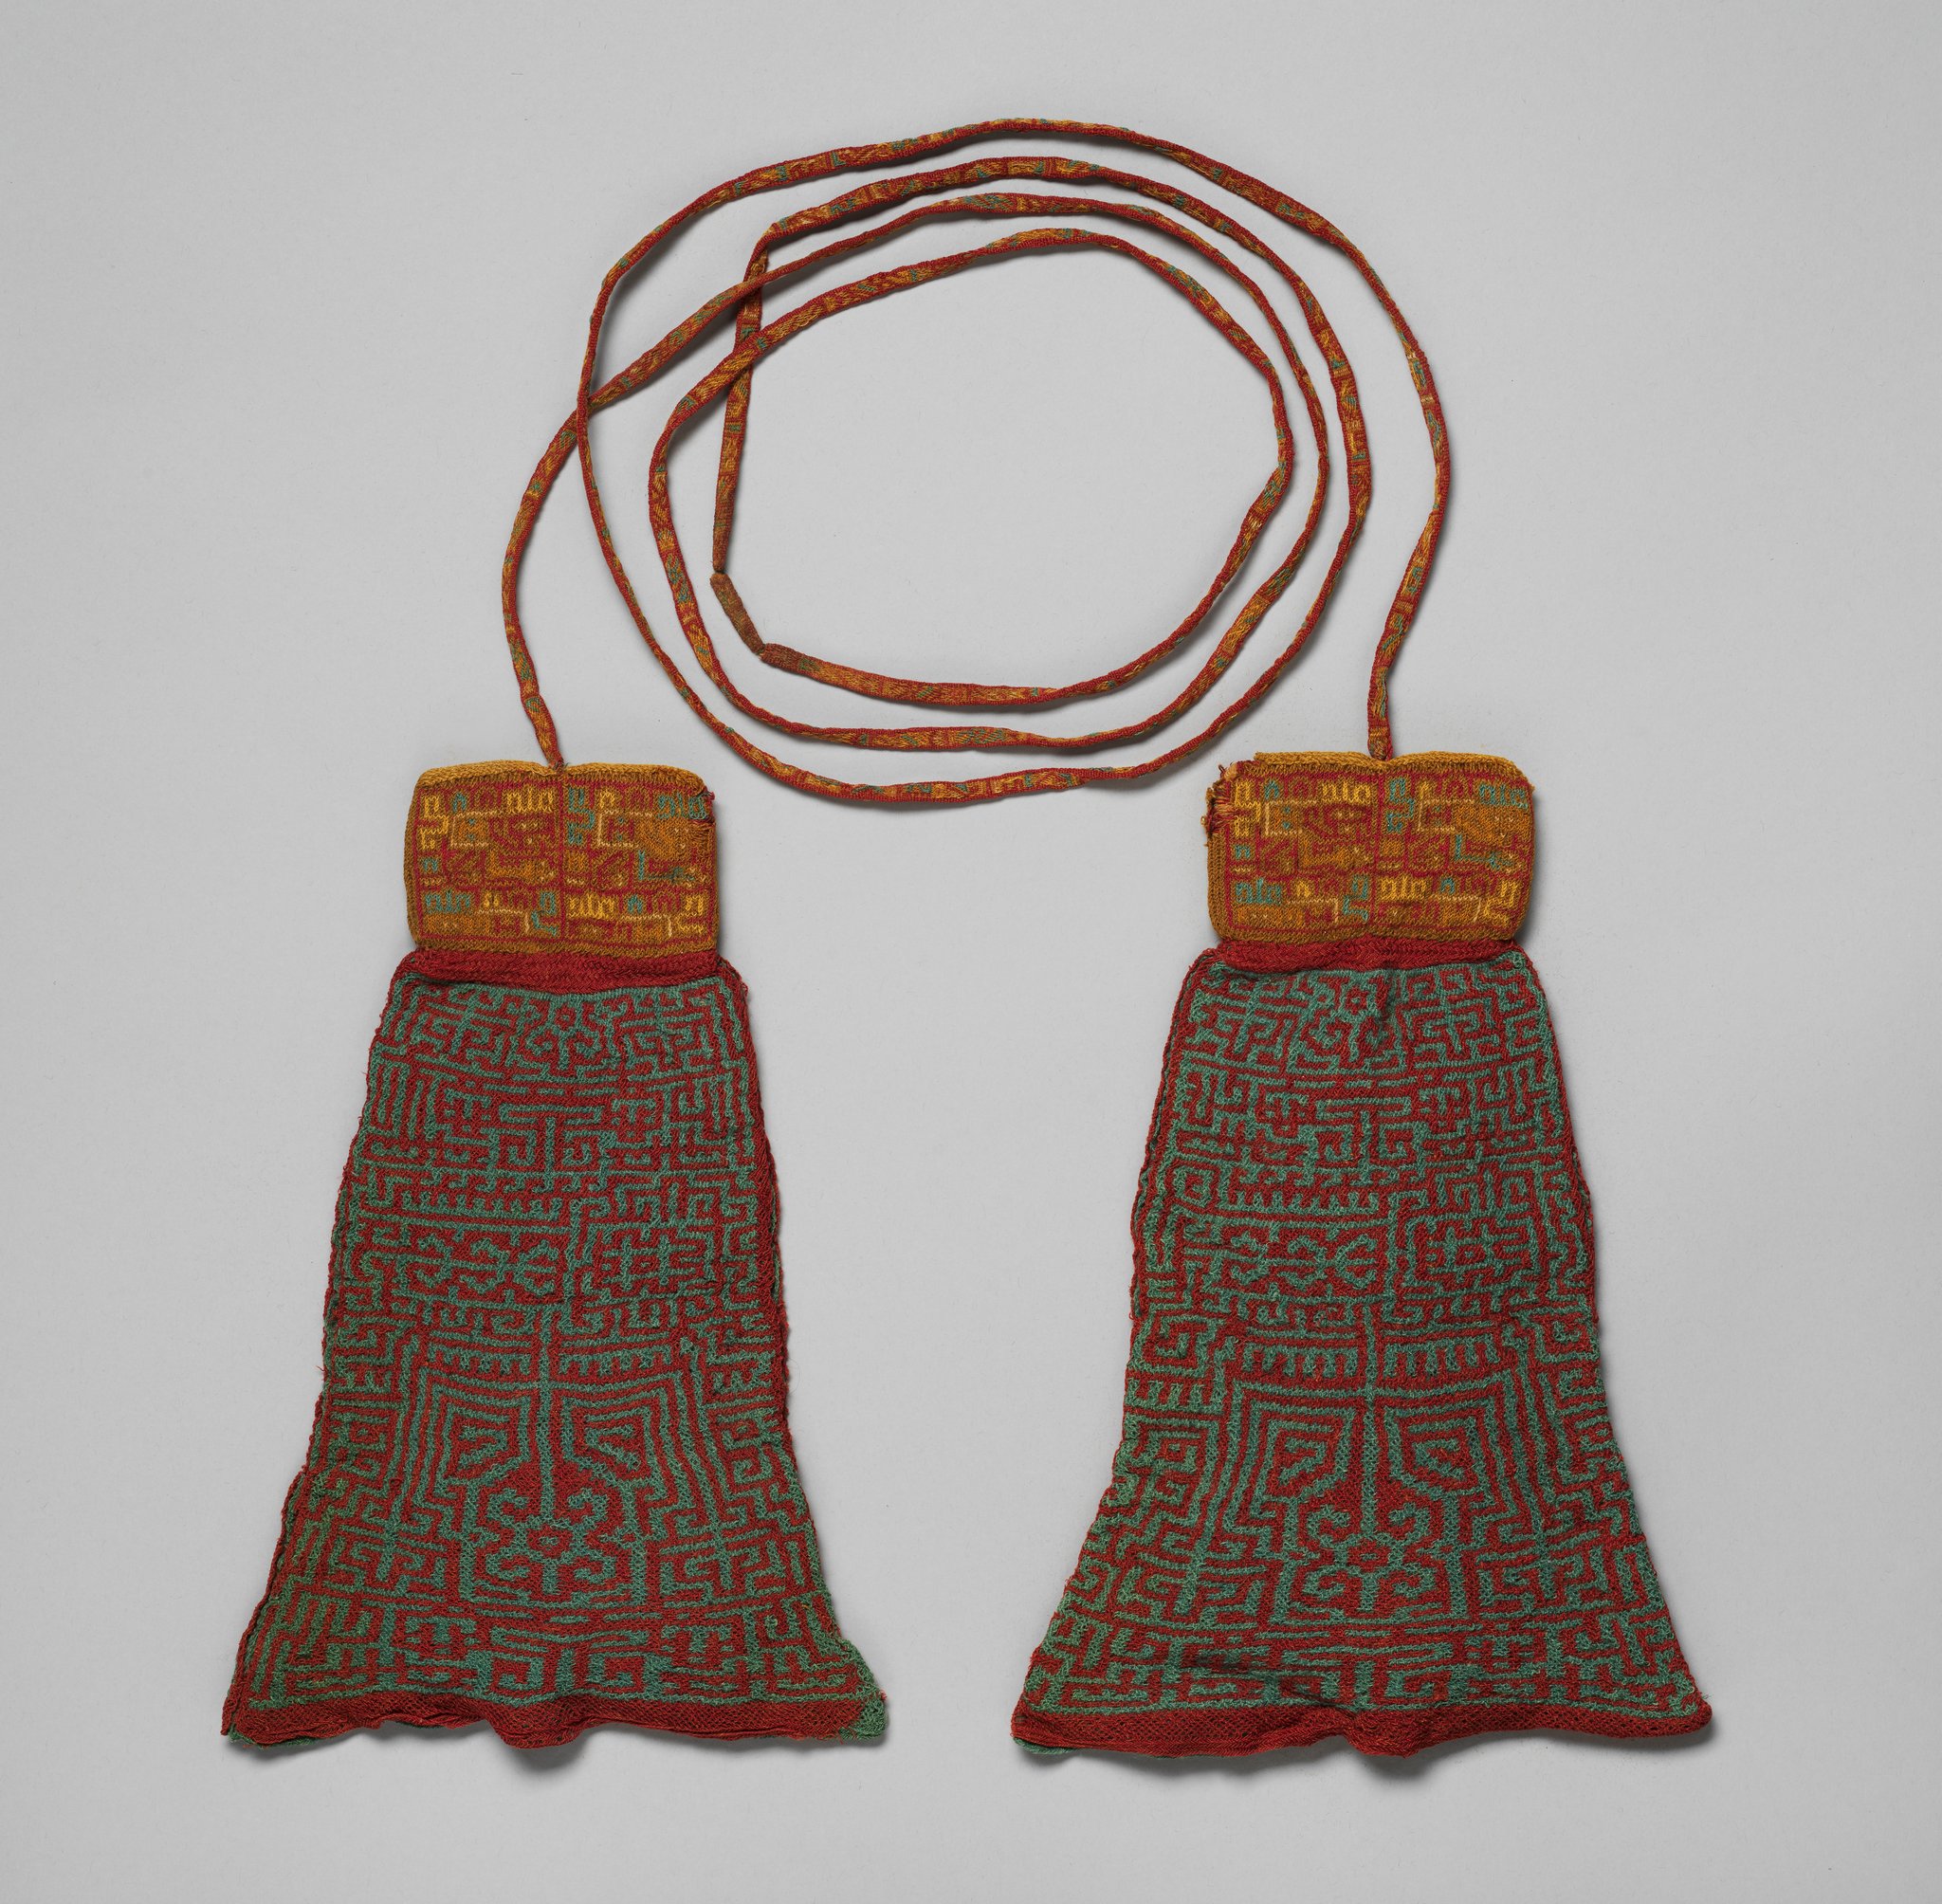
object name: tassel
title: Headband with ornamental tassels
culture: nasca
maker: nasca artist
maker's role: artist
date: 501-800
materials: animal fiber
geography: peru